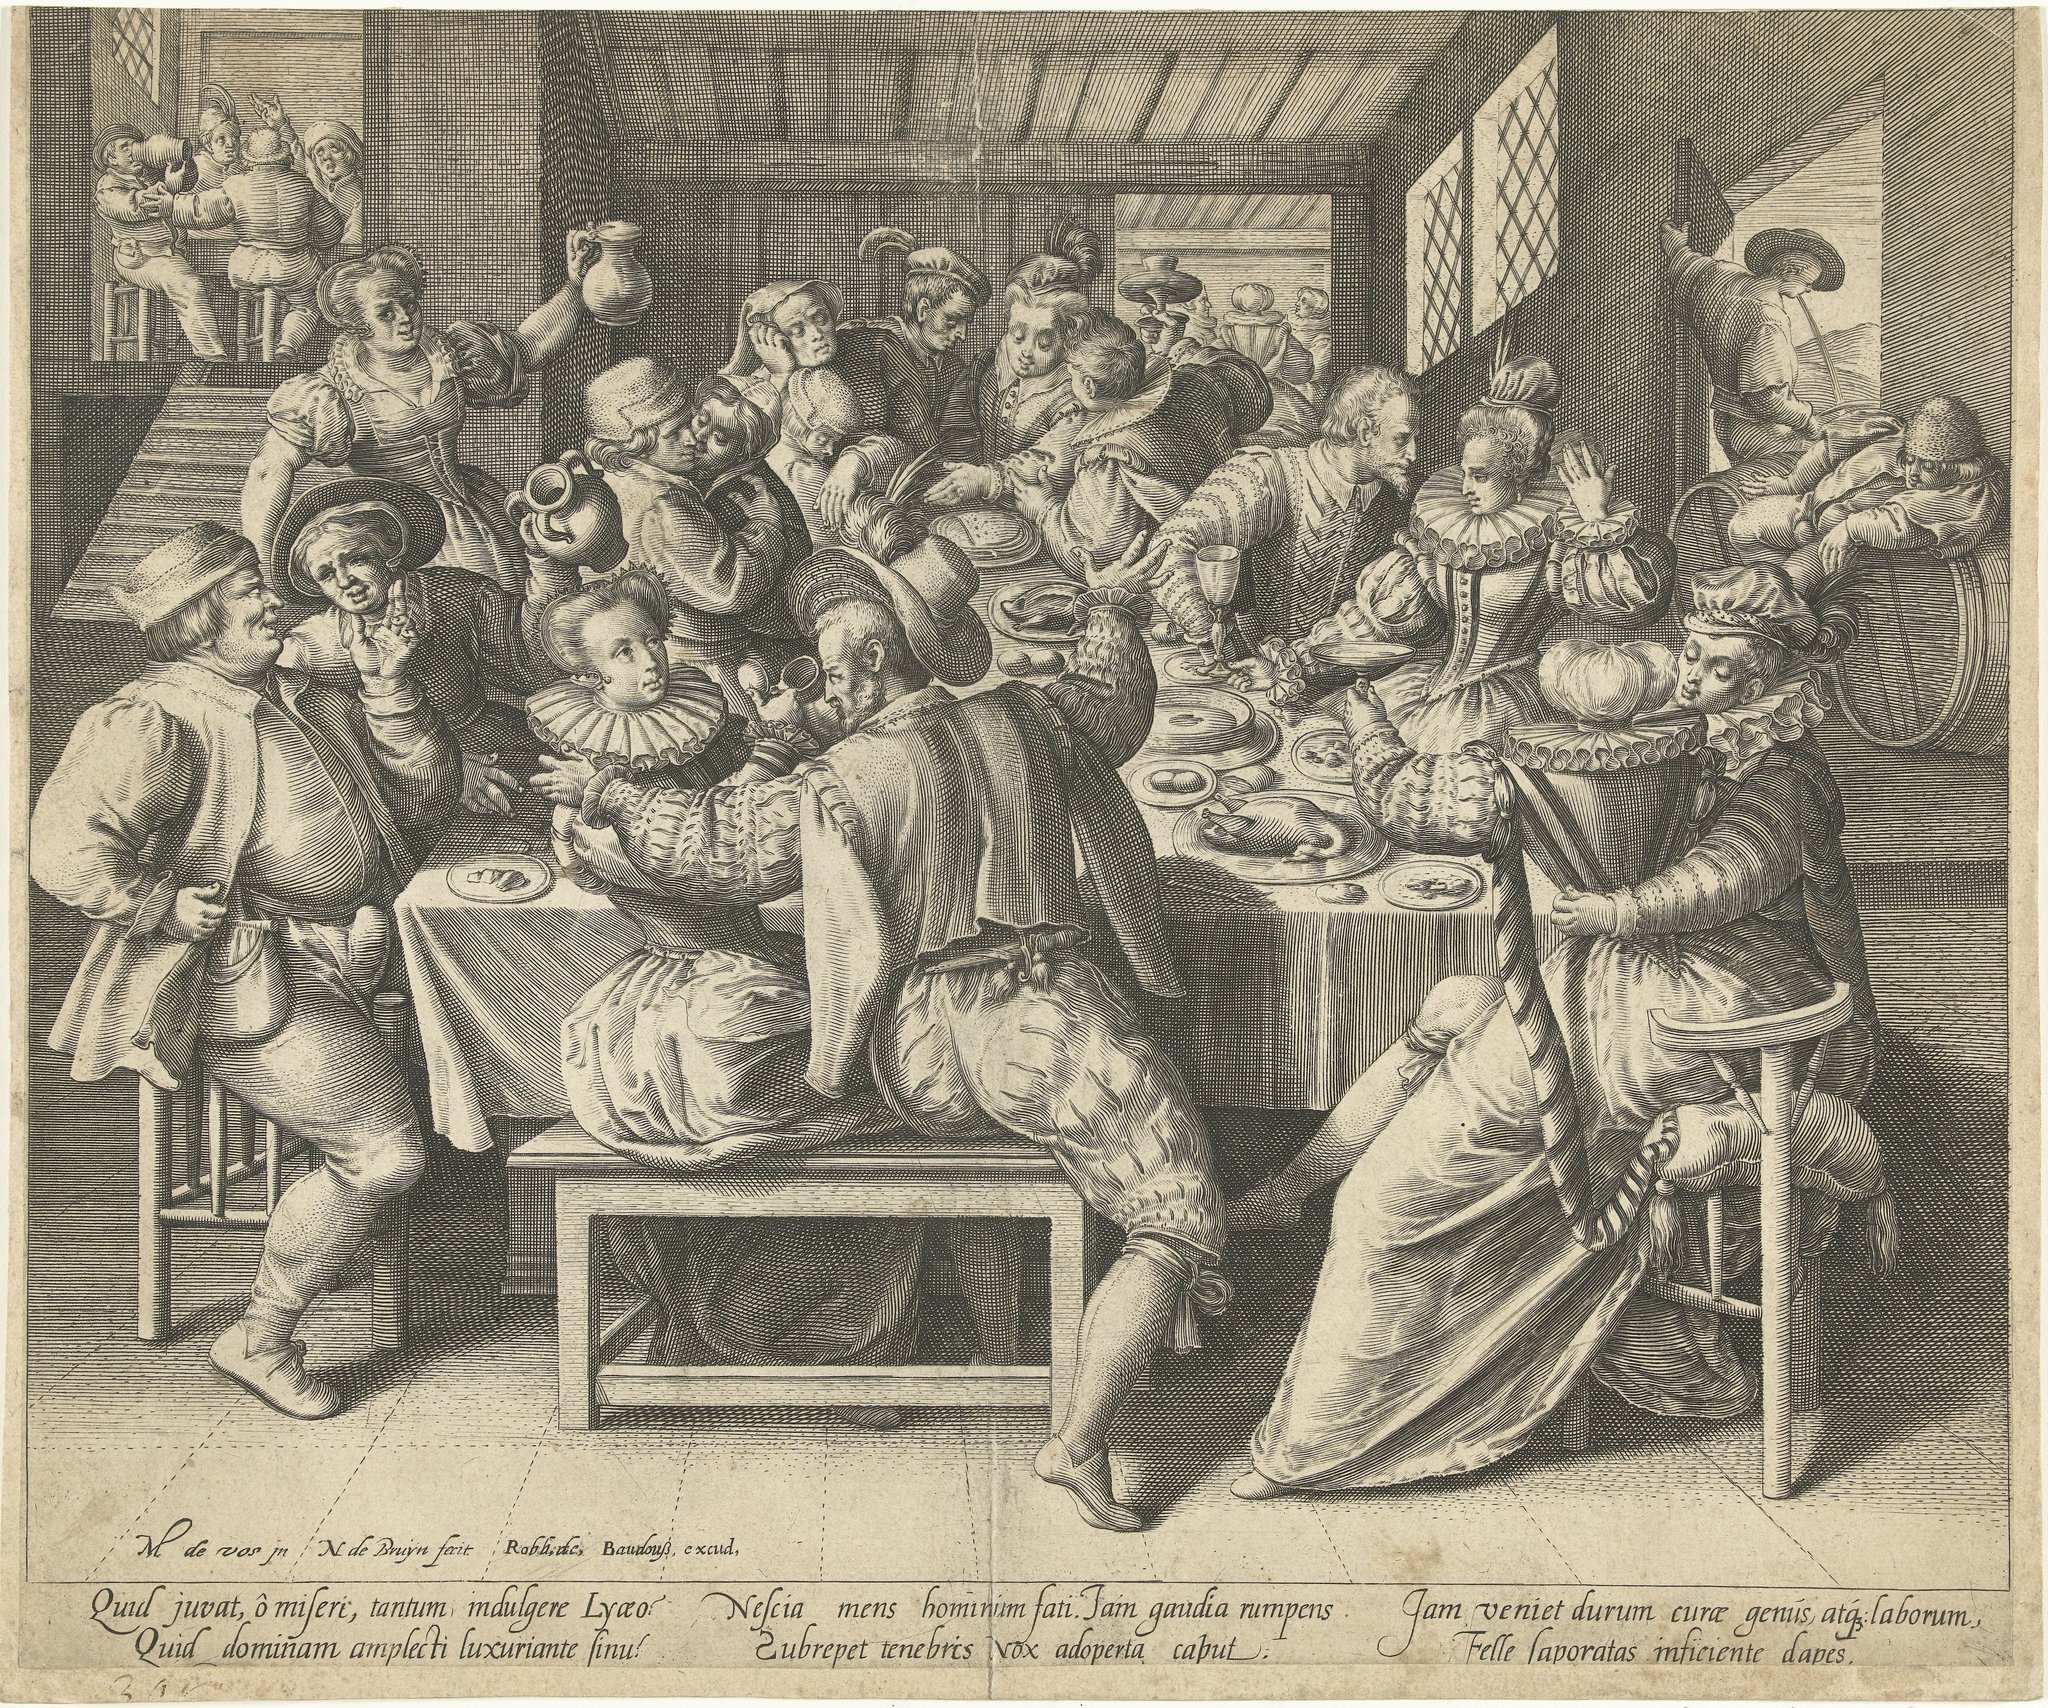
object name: print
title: Feestend gezelschap aan tafel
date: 1581-1656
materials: paper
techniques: engraving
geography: netherlands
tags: sleeves, head-gear: cap (+ men's clothes), codpiece (cover for the genitals), head-gear: hat (+ men's clothes), clothes, costume (+ women's clothes), neck-gear ~ clothing (with name) (+ women's clothes), clothes, costume (+ men's clothes), drunkenness, courting, trousers, breeches, etc. (breeches) (+ men's clothes), clothing for the upper part of the body (doublet) (+ men's clothes), private festivities, merry company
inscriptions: collector's mark: Lugt 2228, caption: ‘Quid juvat, o miseri; tantum indulgere Lyceo...Felle saporatas inficiente dapes’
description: Verbeelding van één van de wijsheden volgens het boek Prediker (nr. 7). In een interieur zit een feestend en vrijend gezelschap van mannen en vrouwen aan een tafel die vol staat met lekkernijen en drank. Volgens Prediker gedragen zij zich dwaas omdat zij genoegen scheppen in een huis vol plezier. In de marge onder een vers met zes regels Latijn.